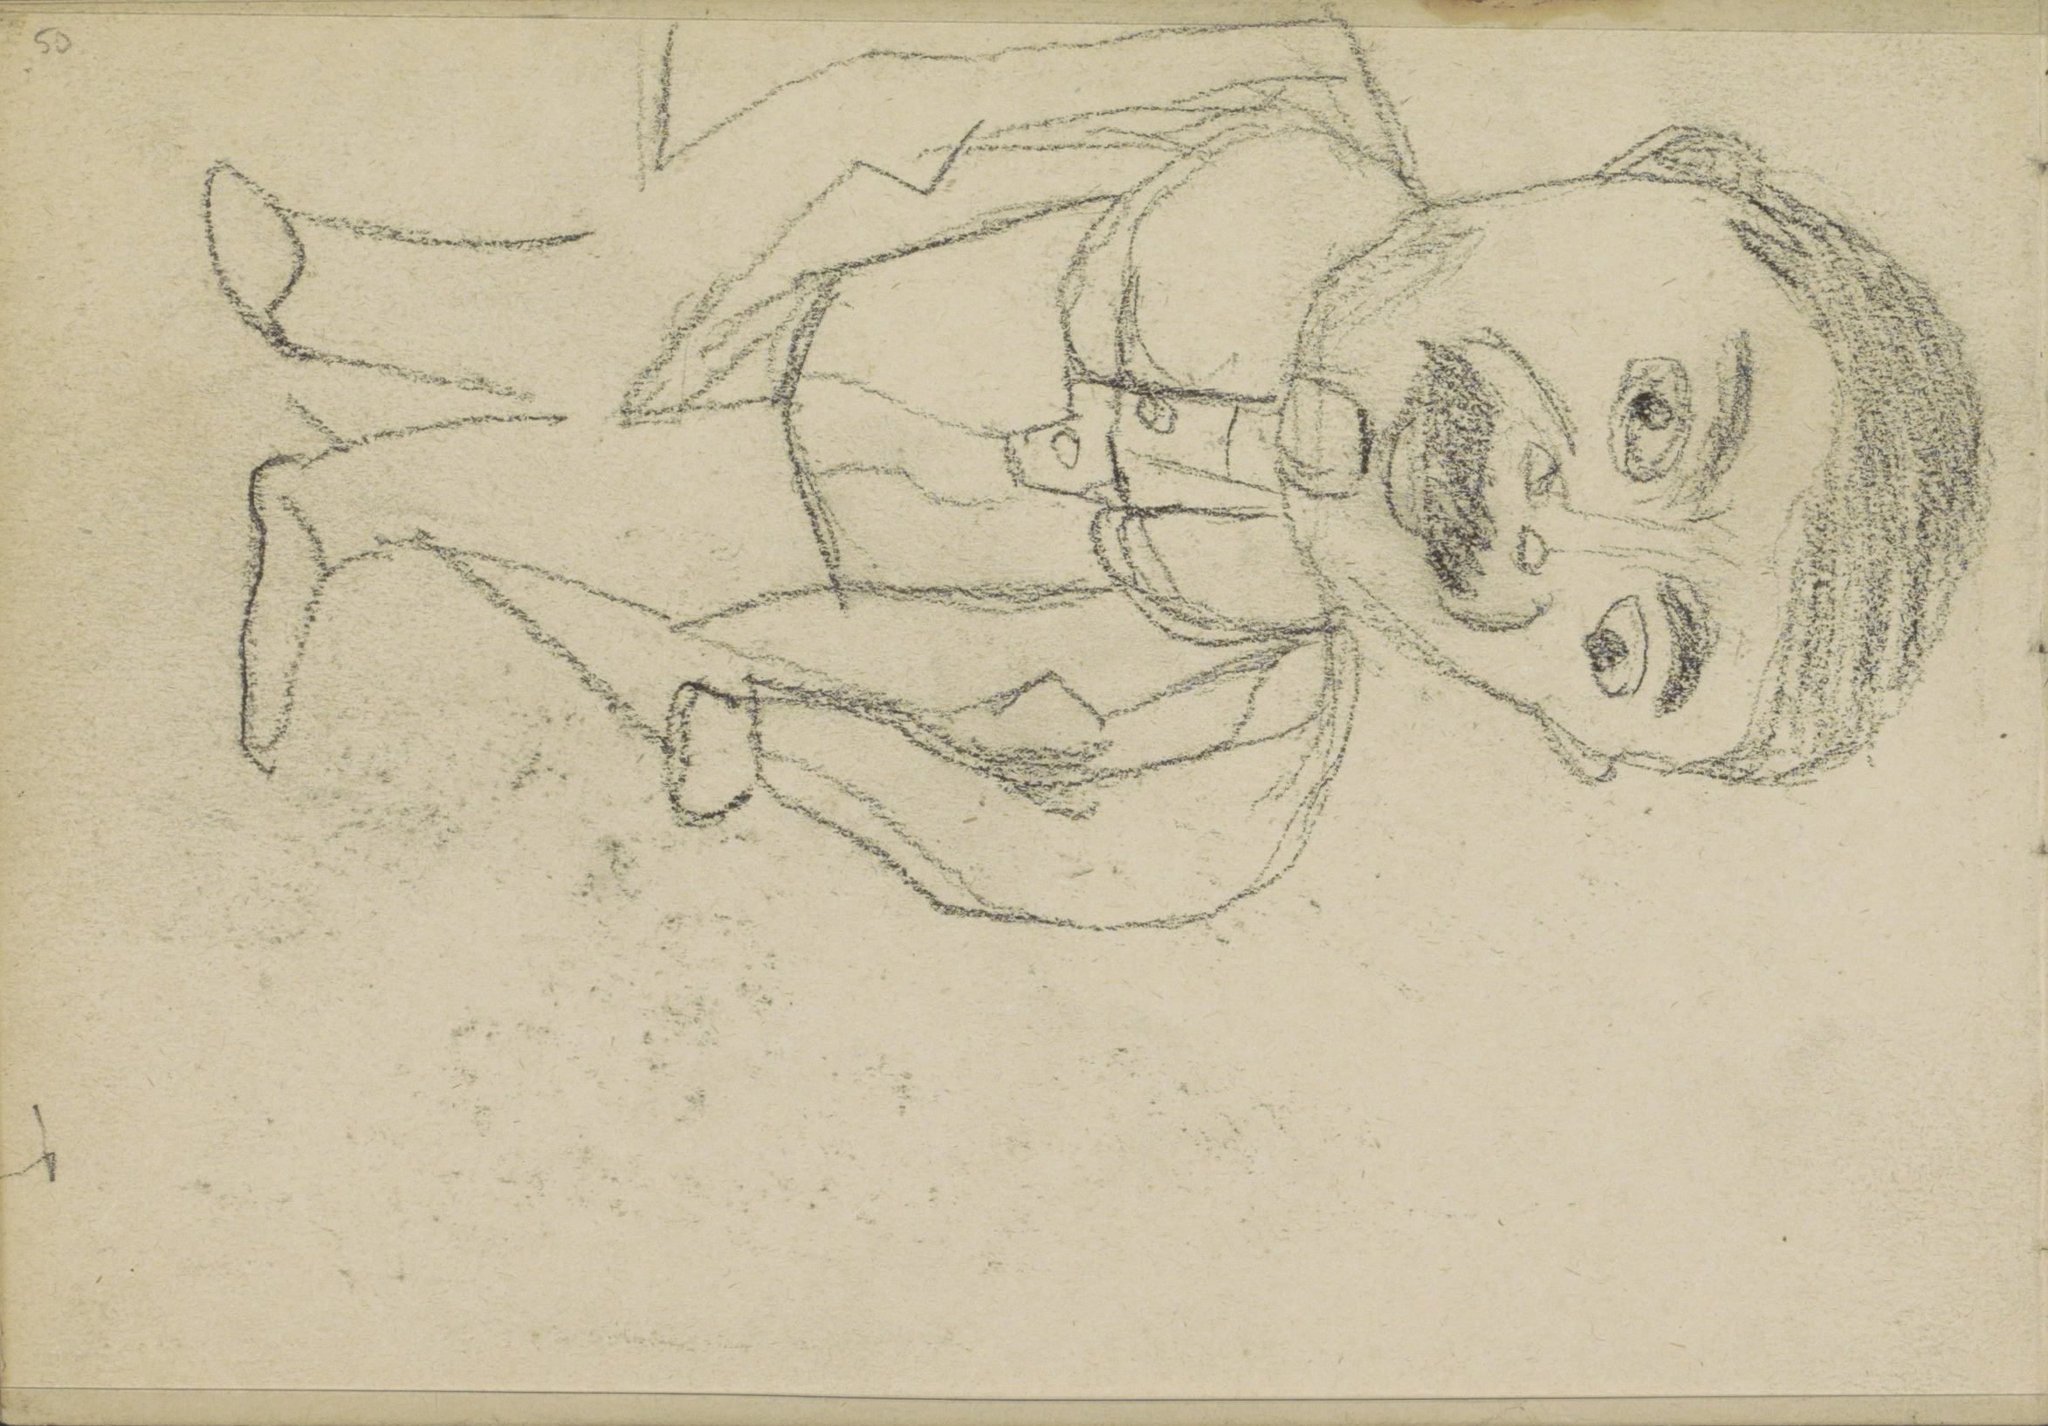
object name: sketchbook leaf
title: Karikatuur van een staande man met stok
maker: willem witsen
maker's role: draughtsman, painter, print maker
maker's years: 1860-1923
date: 1906-1907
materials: chalk, paper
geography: wijk bij duurstede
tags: standing figure, caricatures (human types), adult man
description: Pagina 50 uit een schetsboek met 25 bladen.